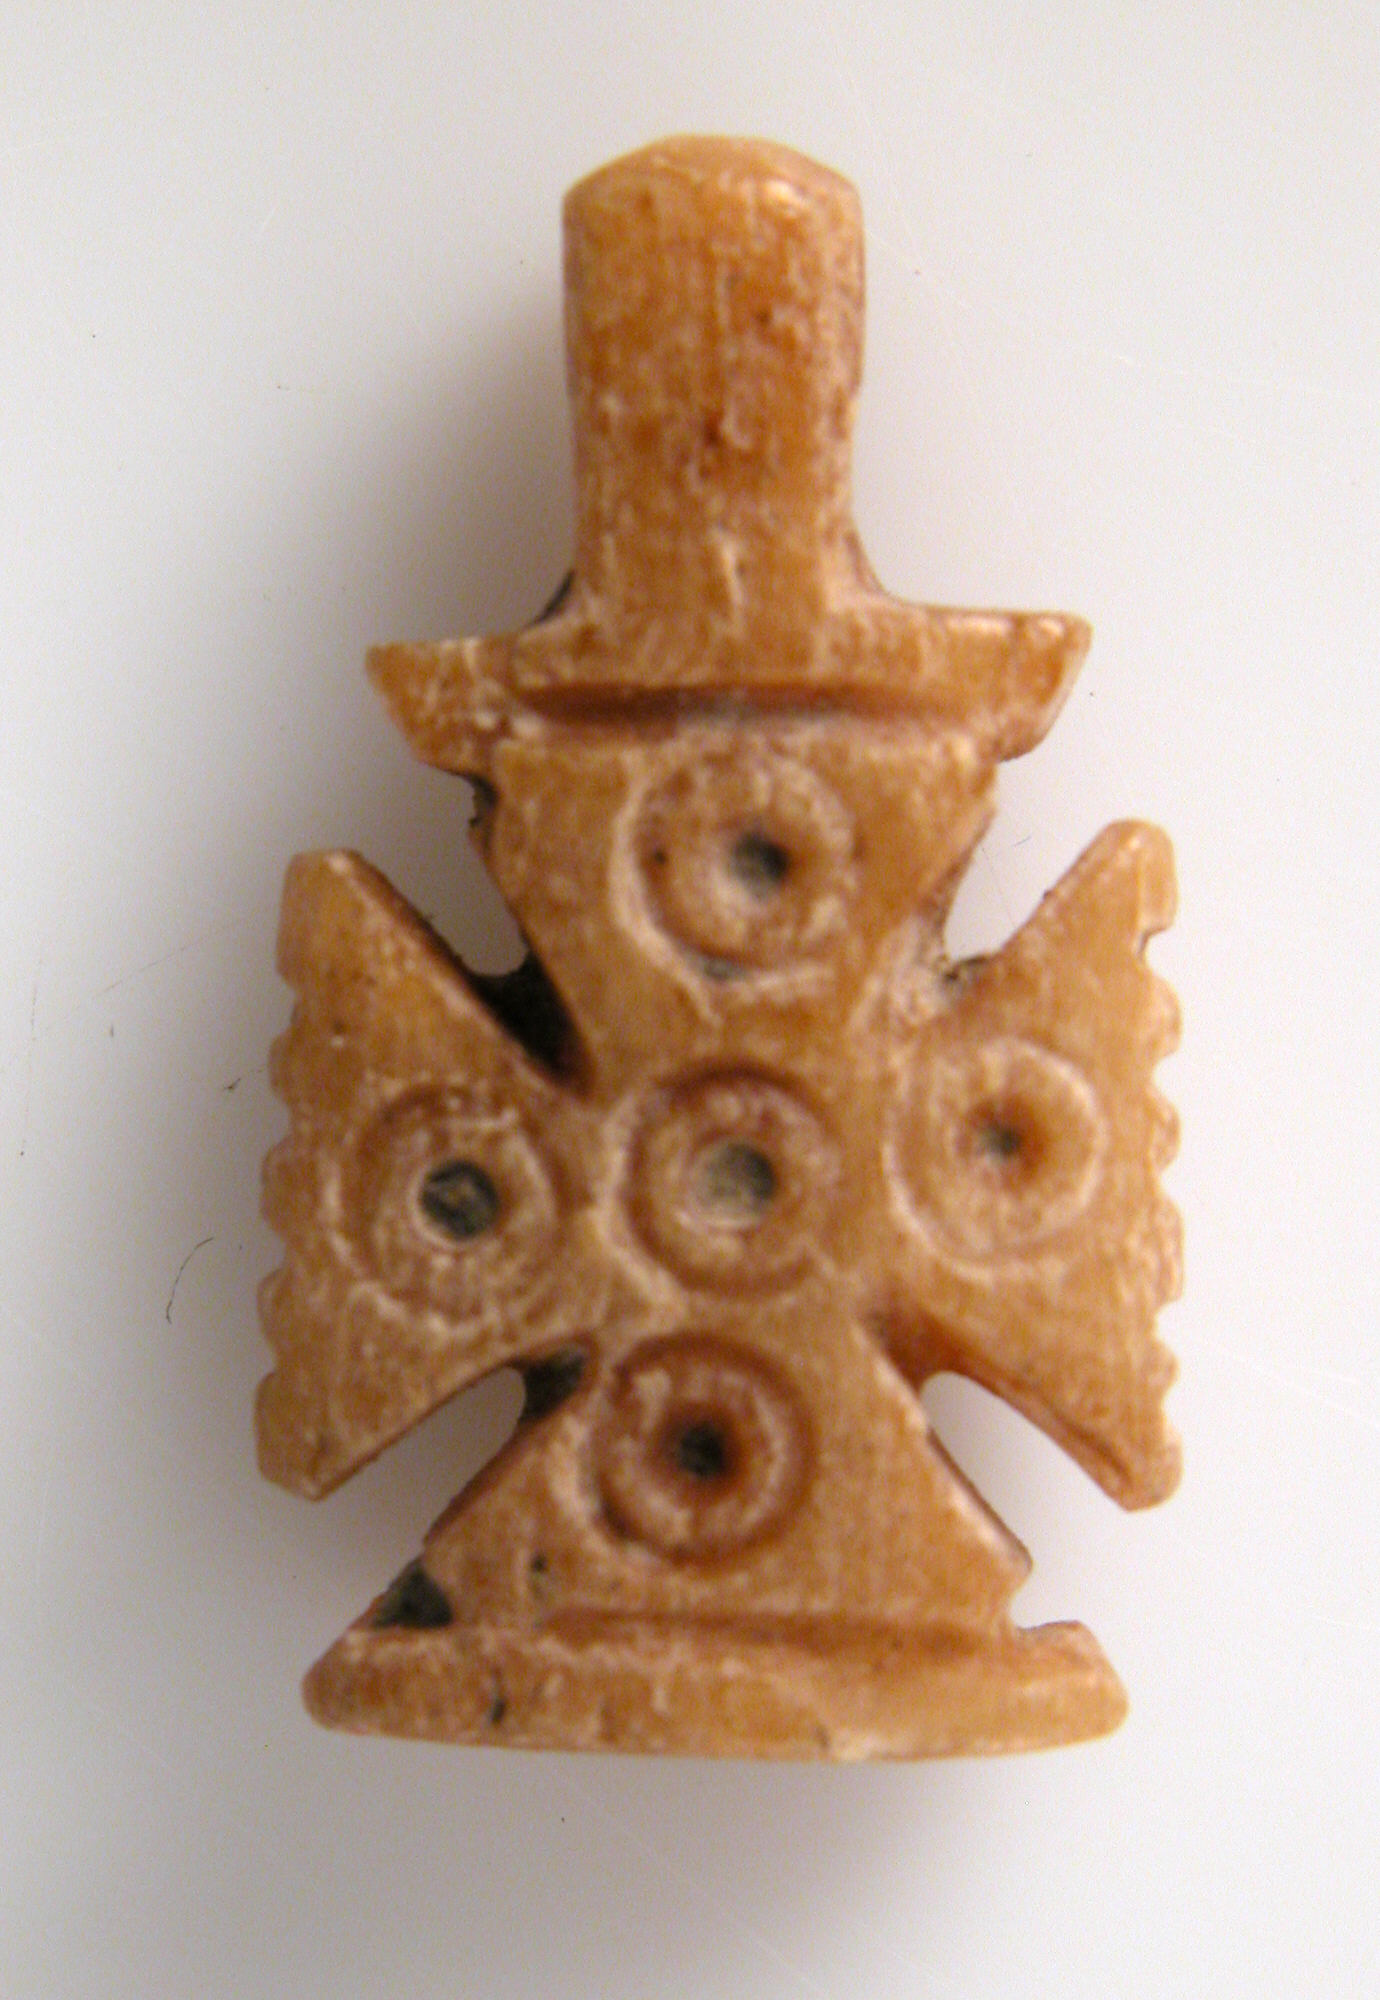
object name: pendant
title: Pendant Cross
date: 401-700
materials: bone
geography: egypt